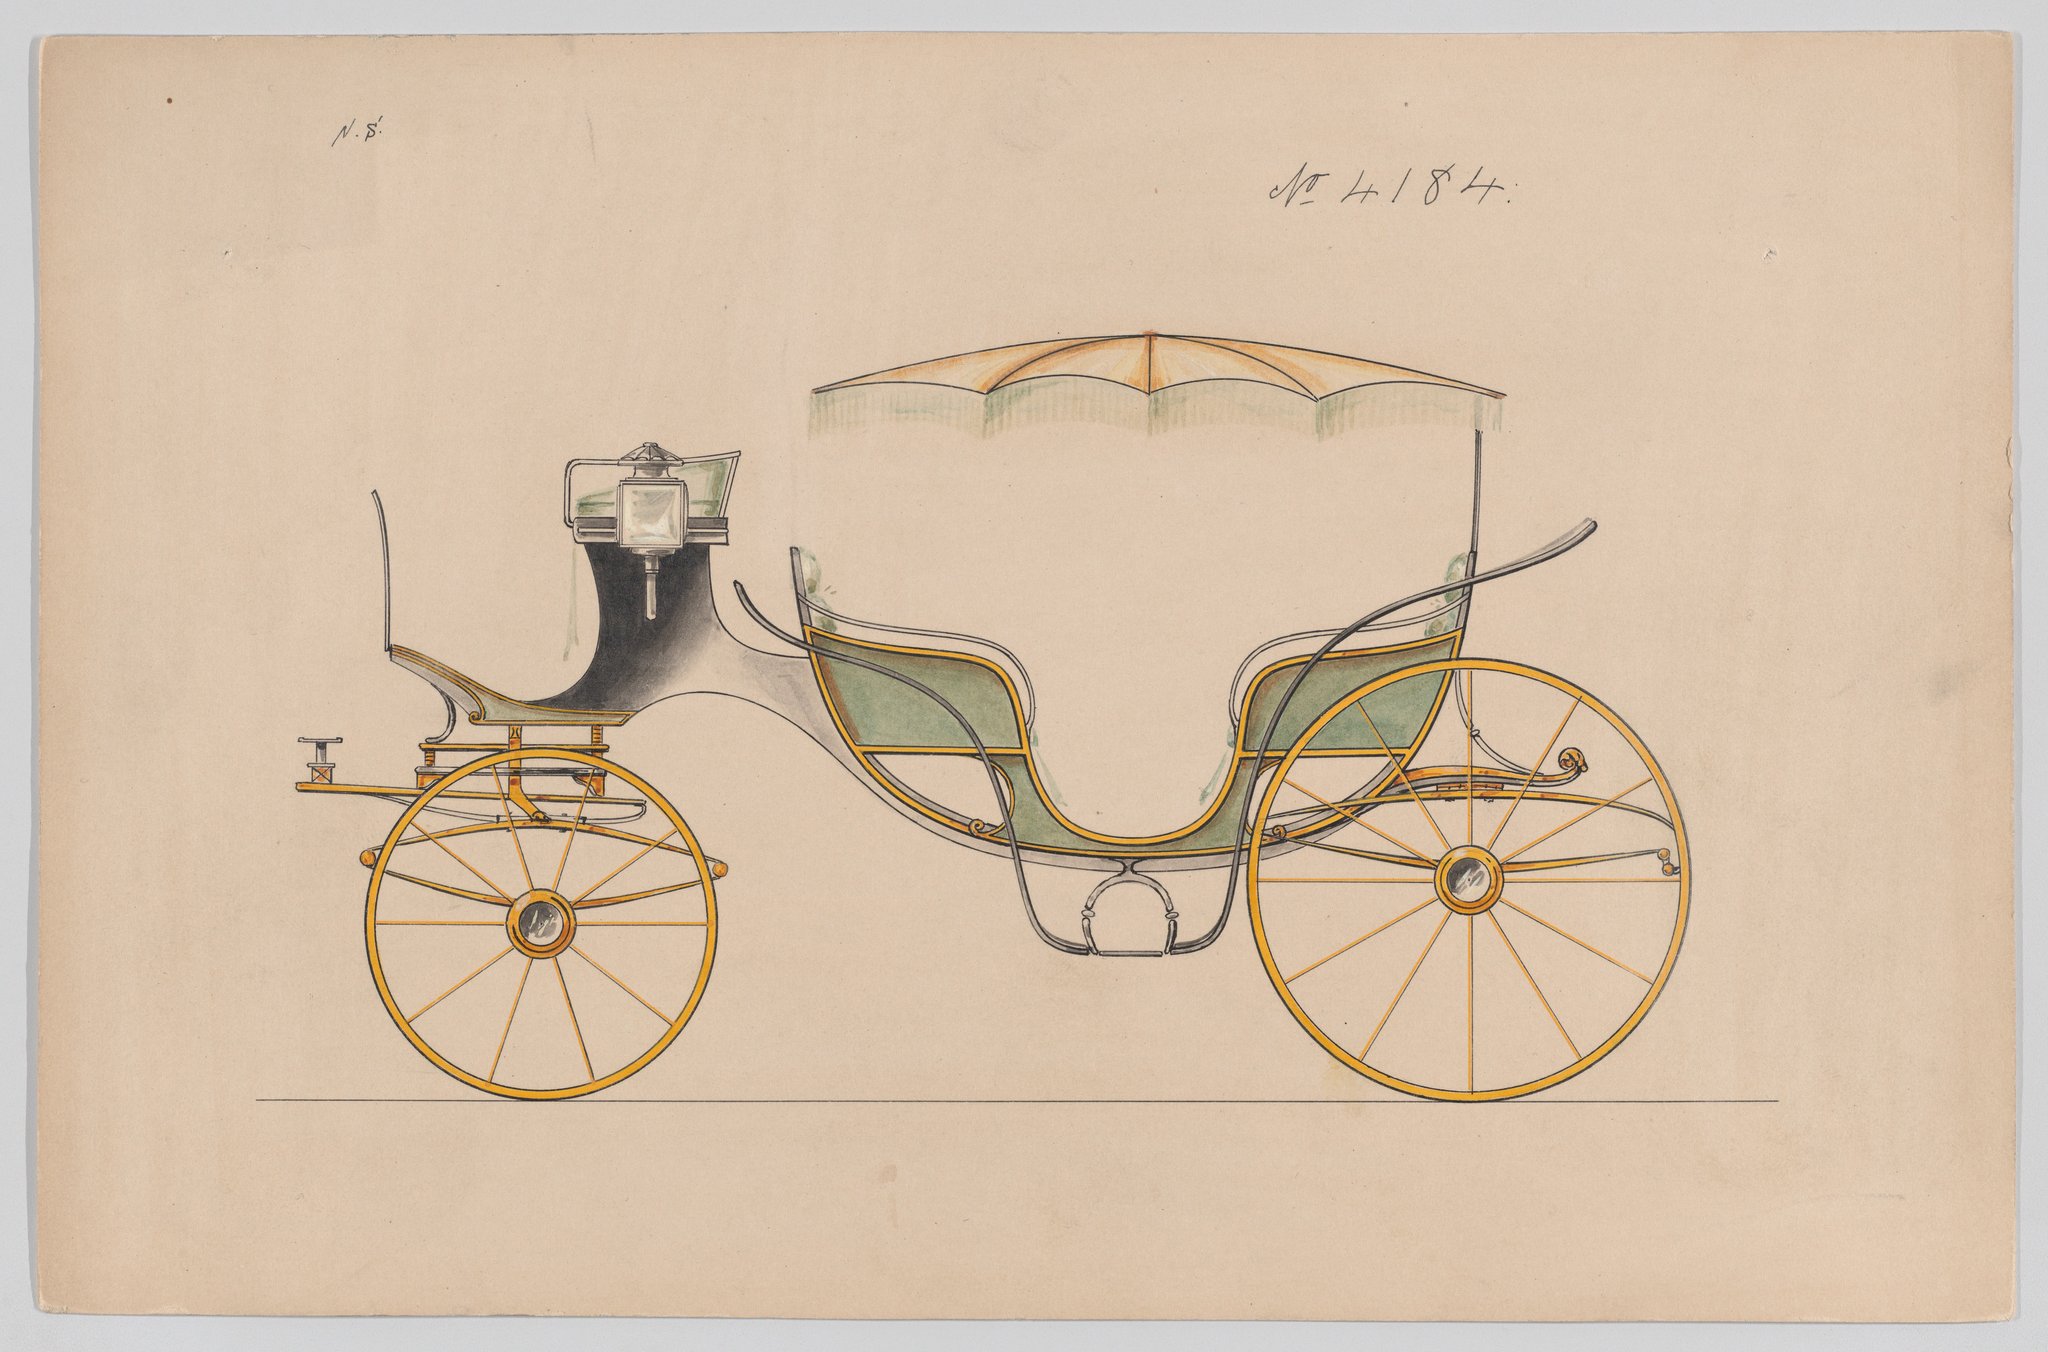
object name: drawing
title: Vis-a-Vis #4184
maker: brewster & co.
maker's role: manufacturer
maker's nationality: american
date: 1892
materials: ink, watercolor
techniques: pen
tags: carriages